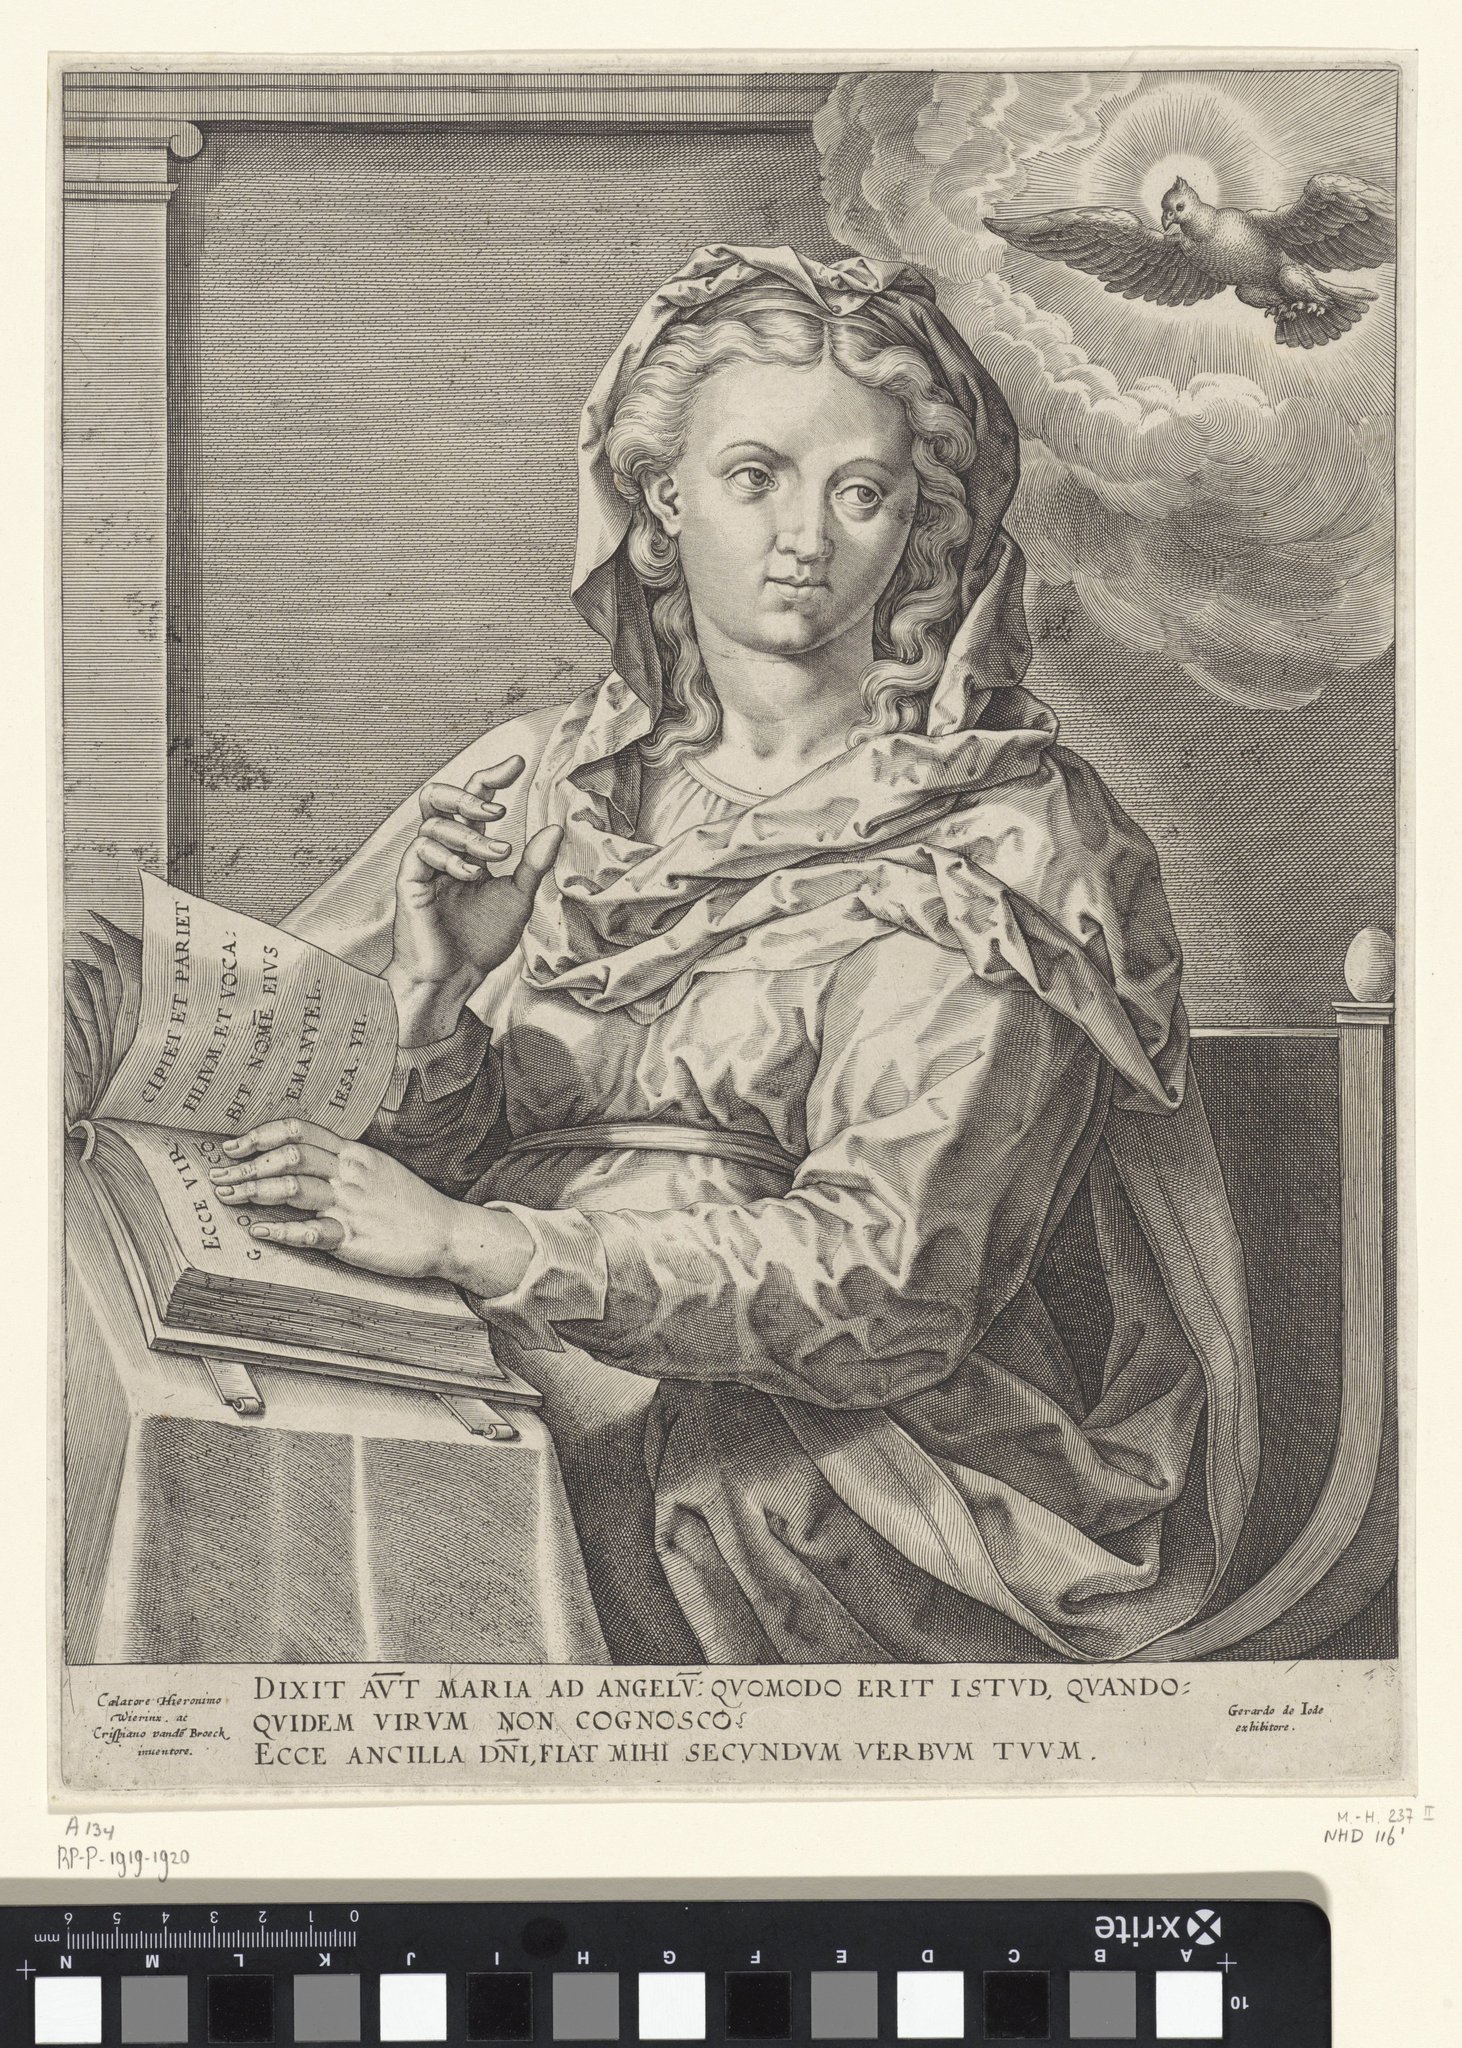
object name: print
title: Annunciatie (Maagd Maria)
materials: paper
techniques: engraving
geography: antwerp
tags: half-length figures of mary and the angel ~ annunciation, the annunciation: mary, usually reading, is visited by the angel (sometimes a woman overhears the conversation)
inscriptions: collector's mark: Lugt 2233, collector's mark: Lugt 2542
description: Maria zit voor een lessenaar te lezen in haar boek. Ze kijkt op naar de Heilige Geest in de gedaante van een duif die boven haar zweeft.